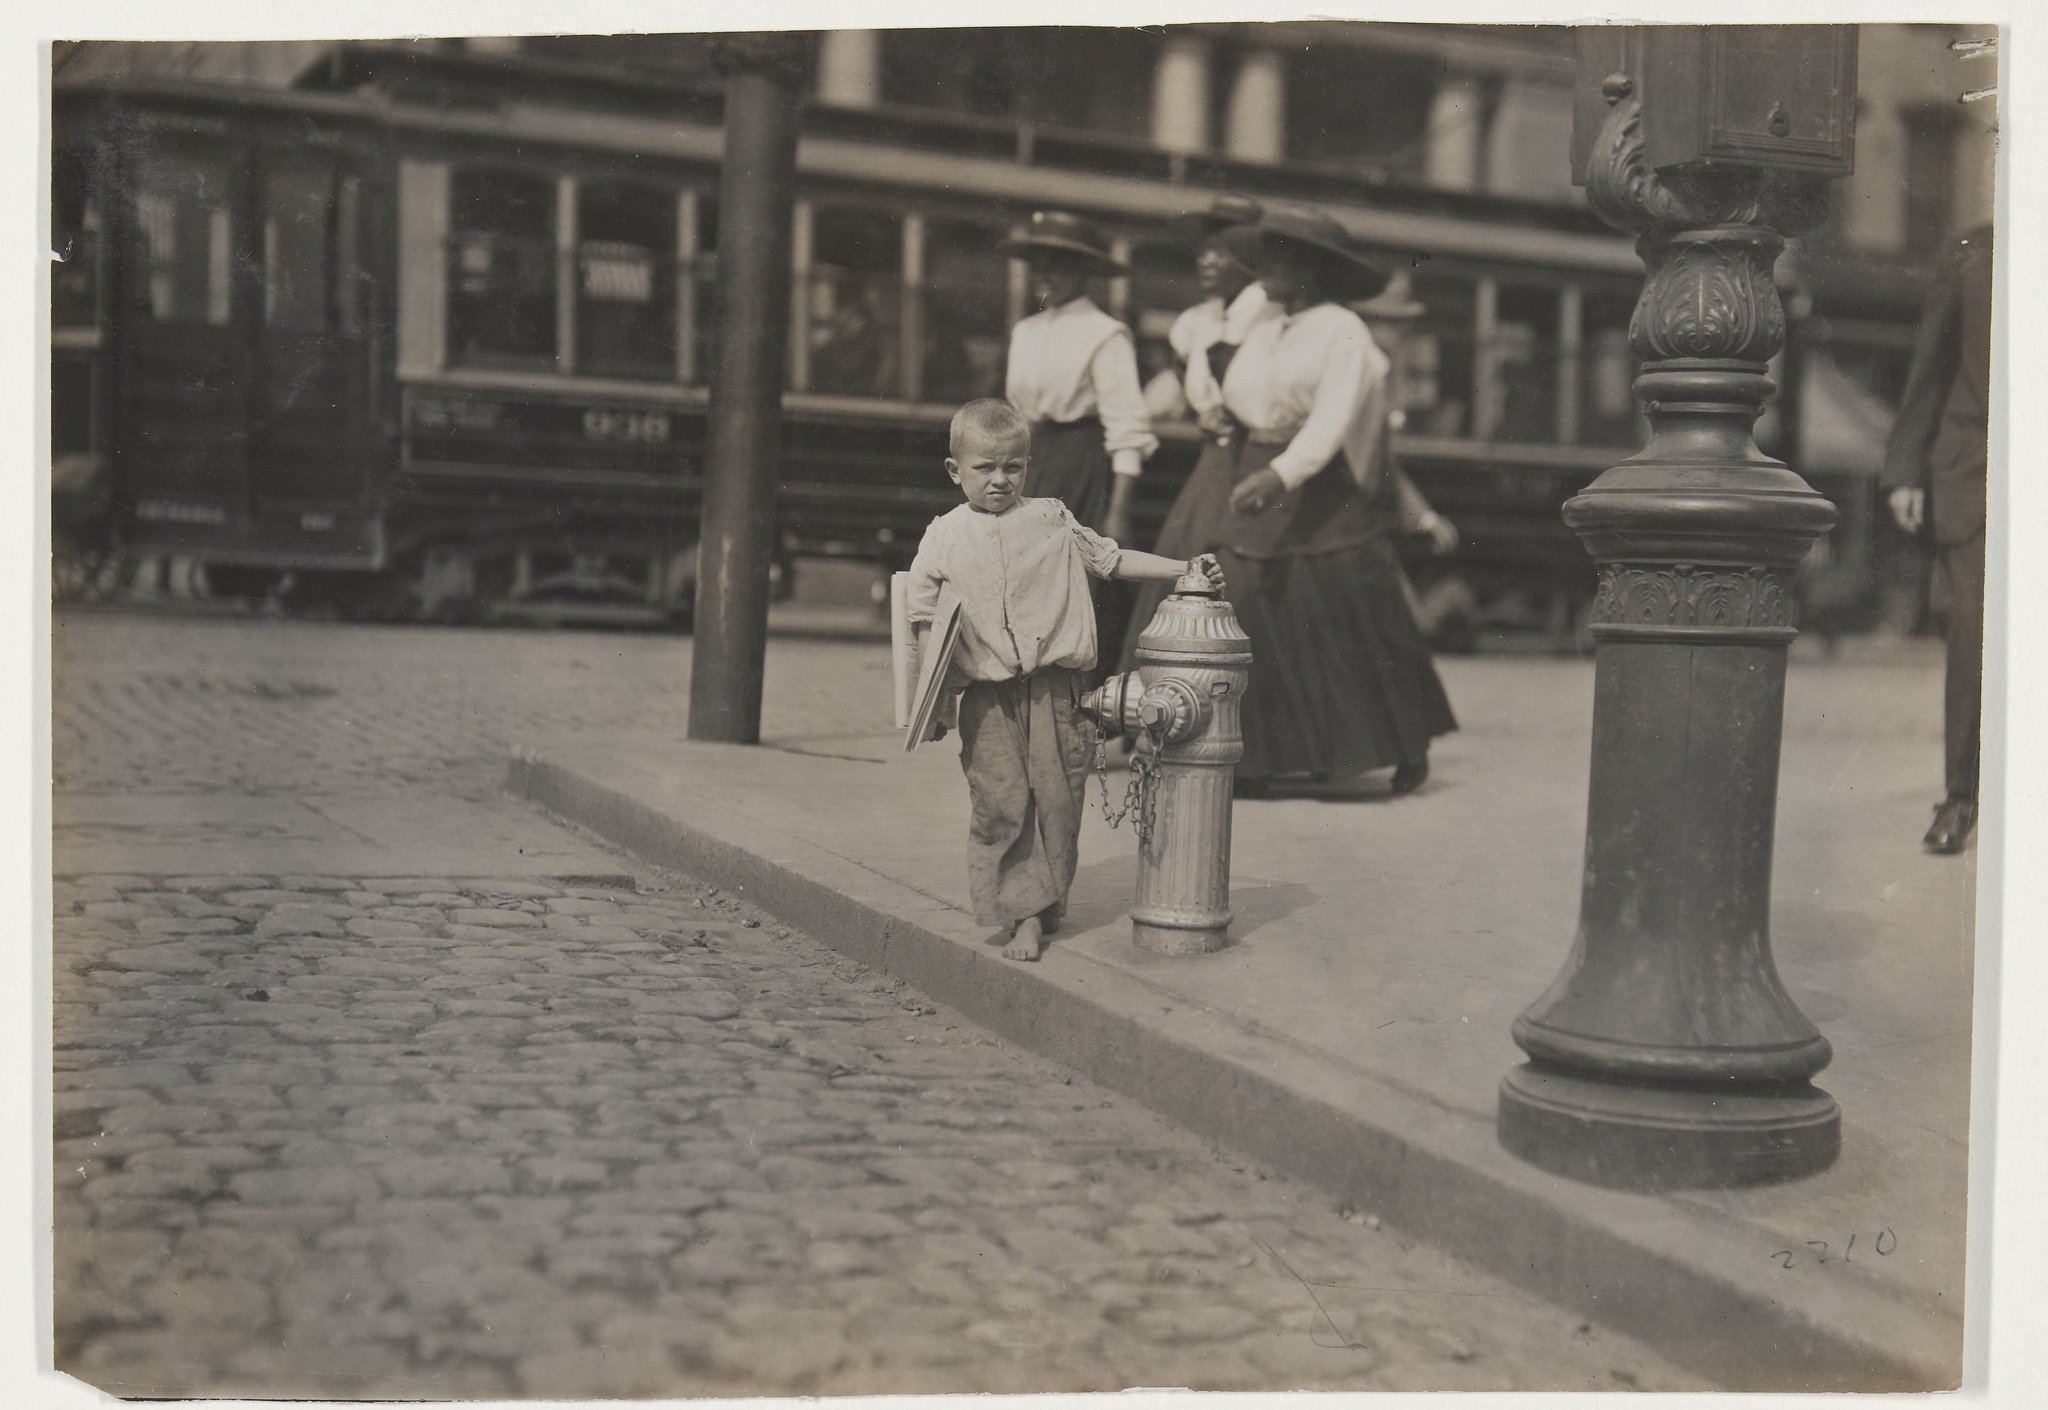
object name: photograph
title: Newspaper Vendor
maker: lewis wickes hine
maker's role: fotograaf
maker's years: 1874-1940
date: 1906-1911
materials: paper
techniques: gelatin silver print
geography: richmond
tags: boy (child between toddler and youth), street-trader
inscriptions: number: ‘2210/ 2210/ 29’, number: ‘2210’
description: Hine portrayed the European immigrants who came to America at the beginning of the 20th century. Life was hard in a big city where hundreds of thousands of people were looking for ways to make a living. Italian women were employed in ‘sweatshops’, sewing workshops, where they were grievously exploited. Even children, like this barefoot newspaper boy, were sent out to earn money.